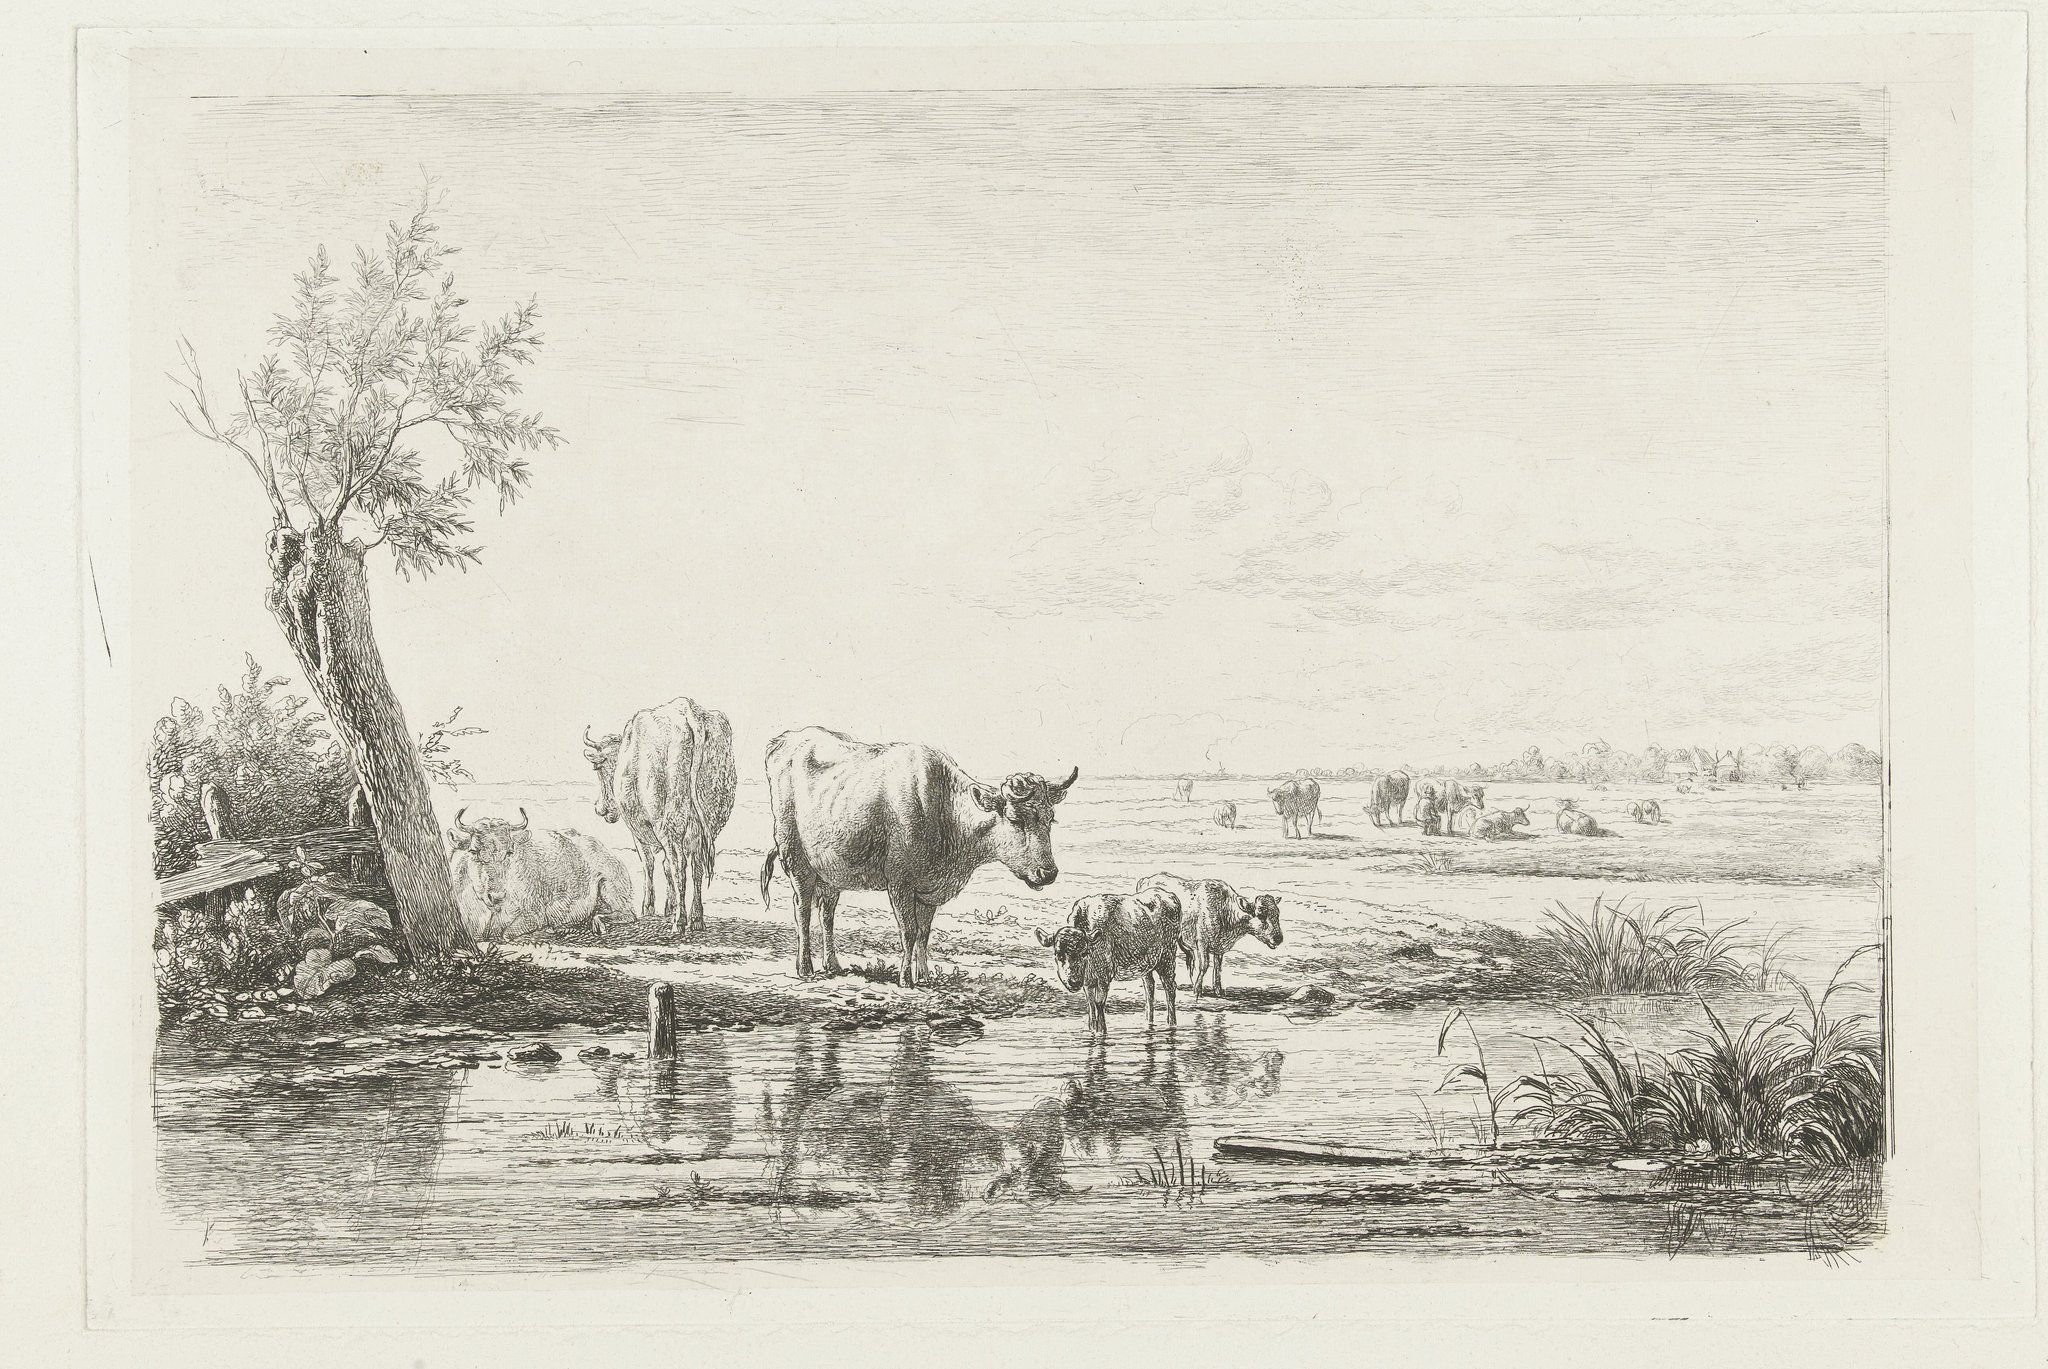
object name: print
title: Weidelandschap met koeien bij water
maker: simon van den berg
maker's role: draughtsman, print maker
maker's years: 1812-1891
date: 1822-1891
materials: paper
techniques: drypoint, etching, roulette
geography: netherlands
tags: cow, water meadows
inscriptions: collector's mark: Lugt 2228